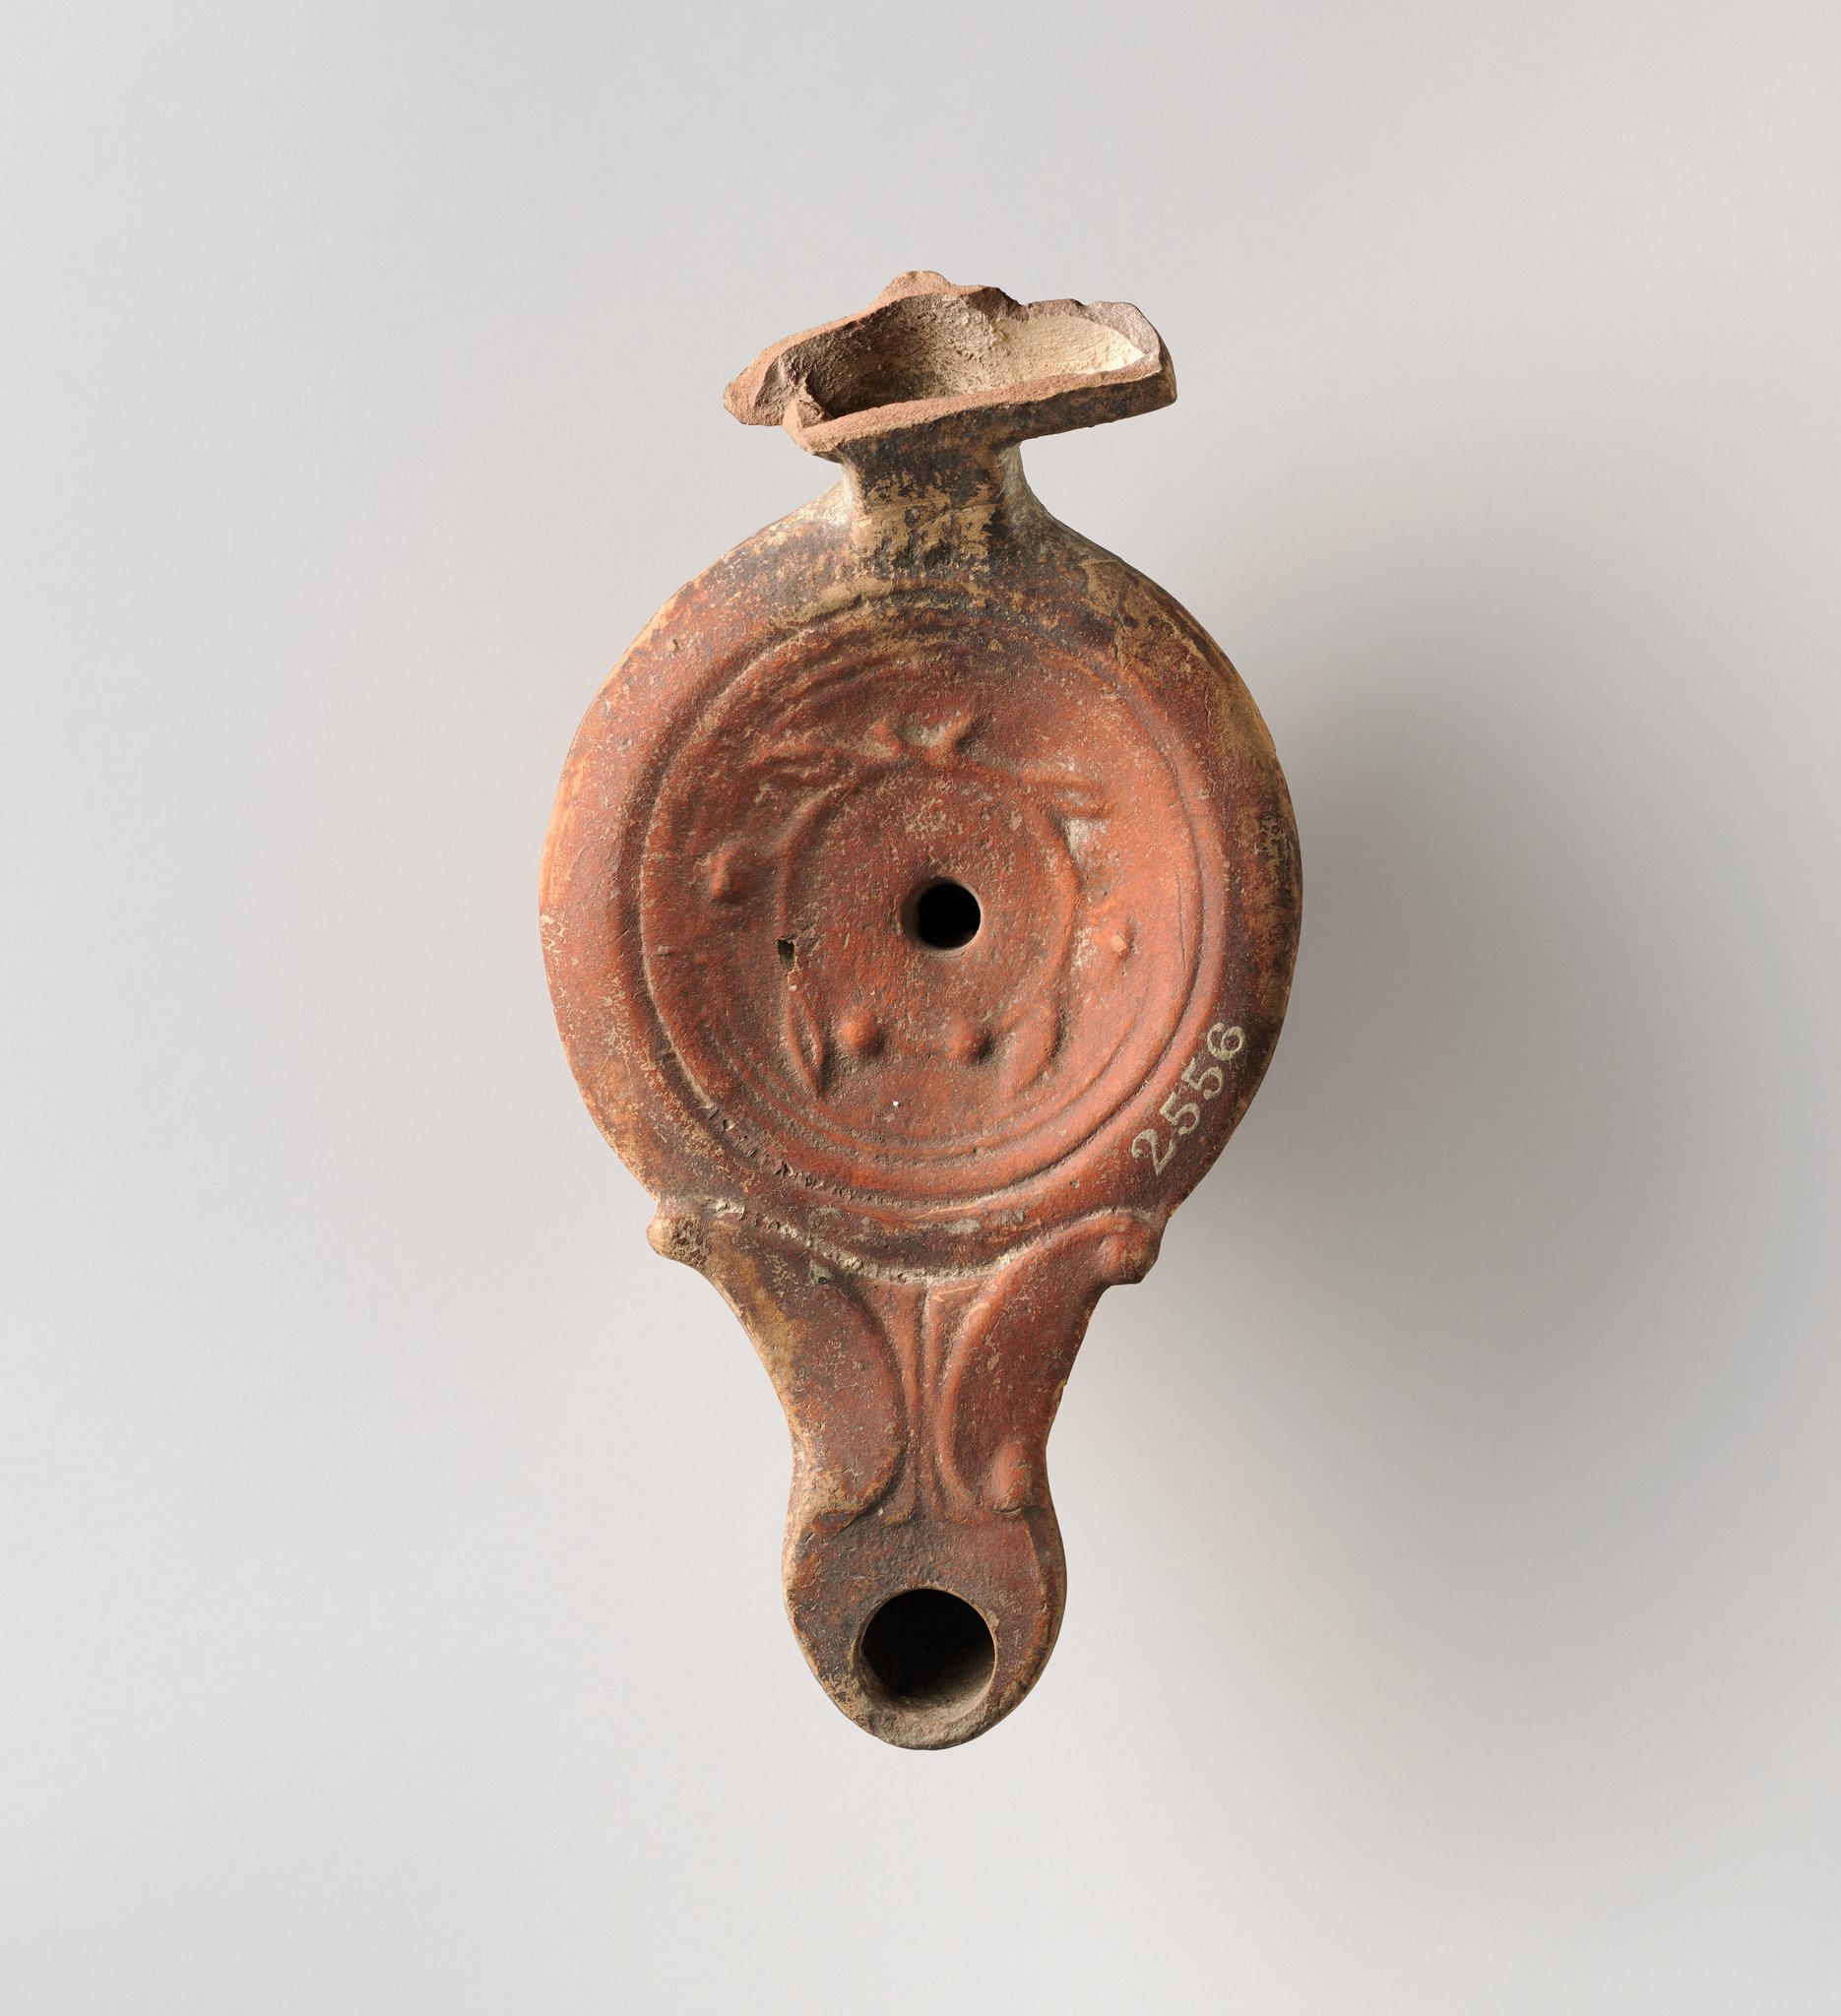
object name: lamp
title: Terracotta oil lamp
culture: roman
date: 40-100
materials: terracotta